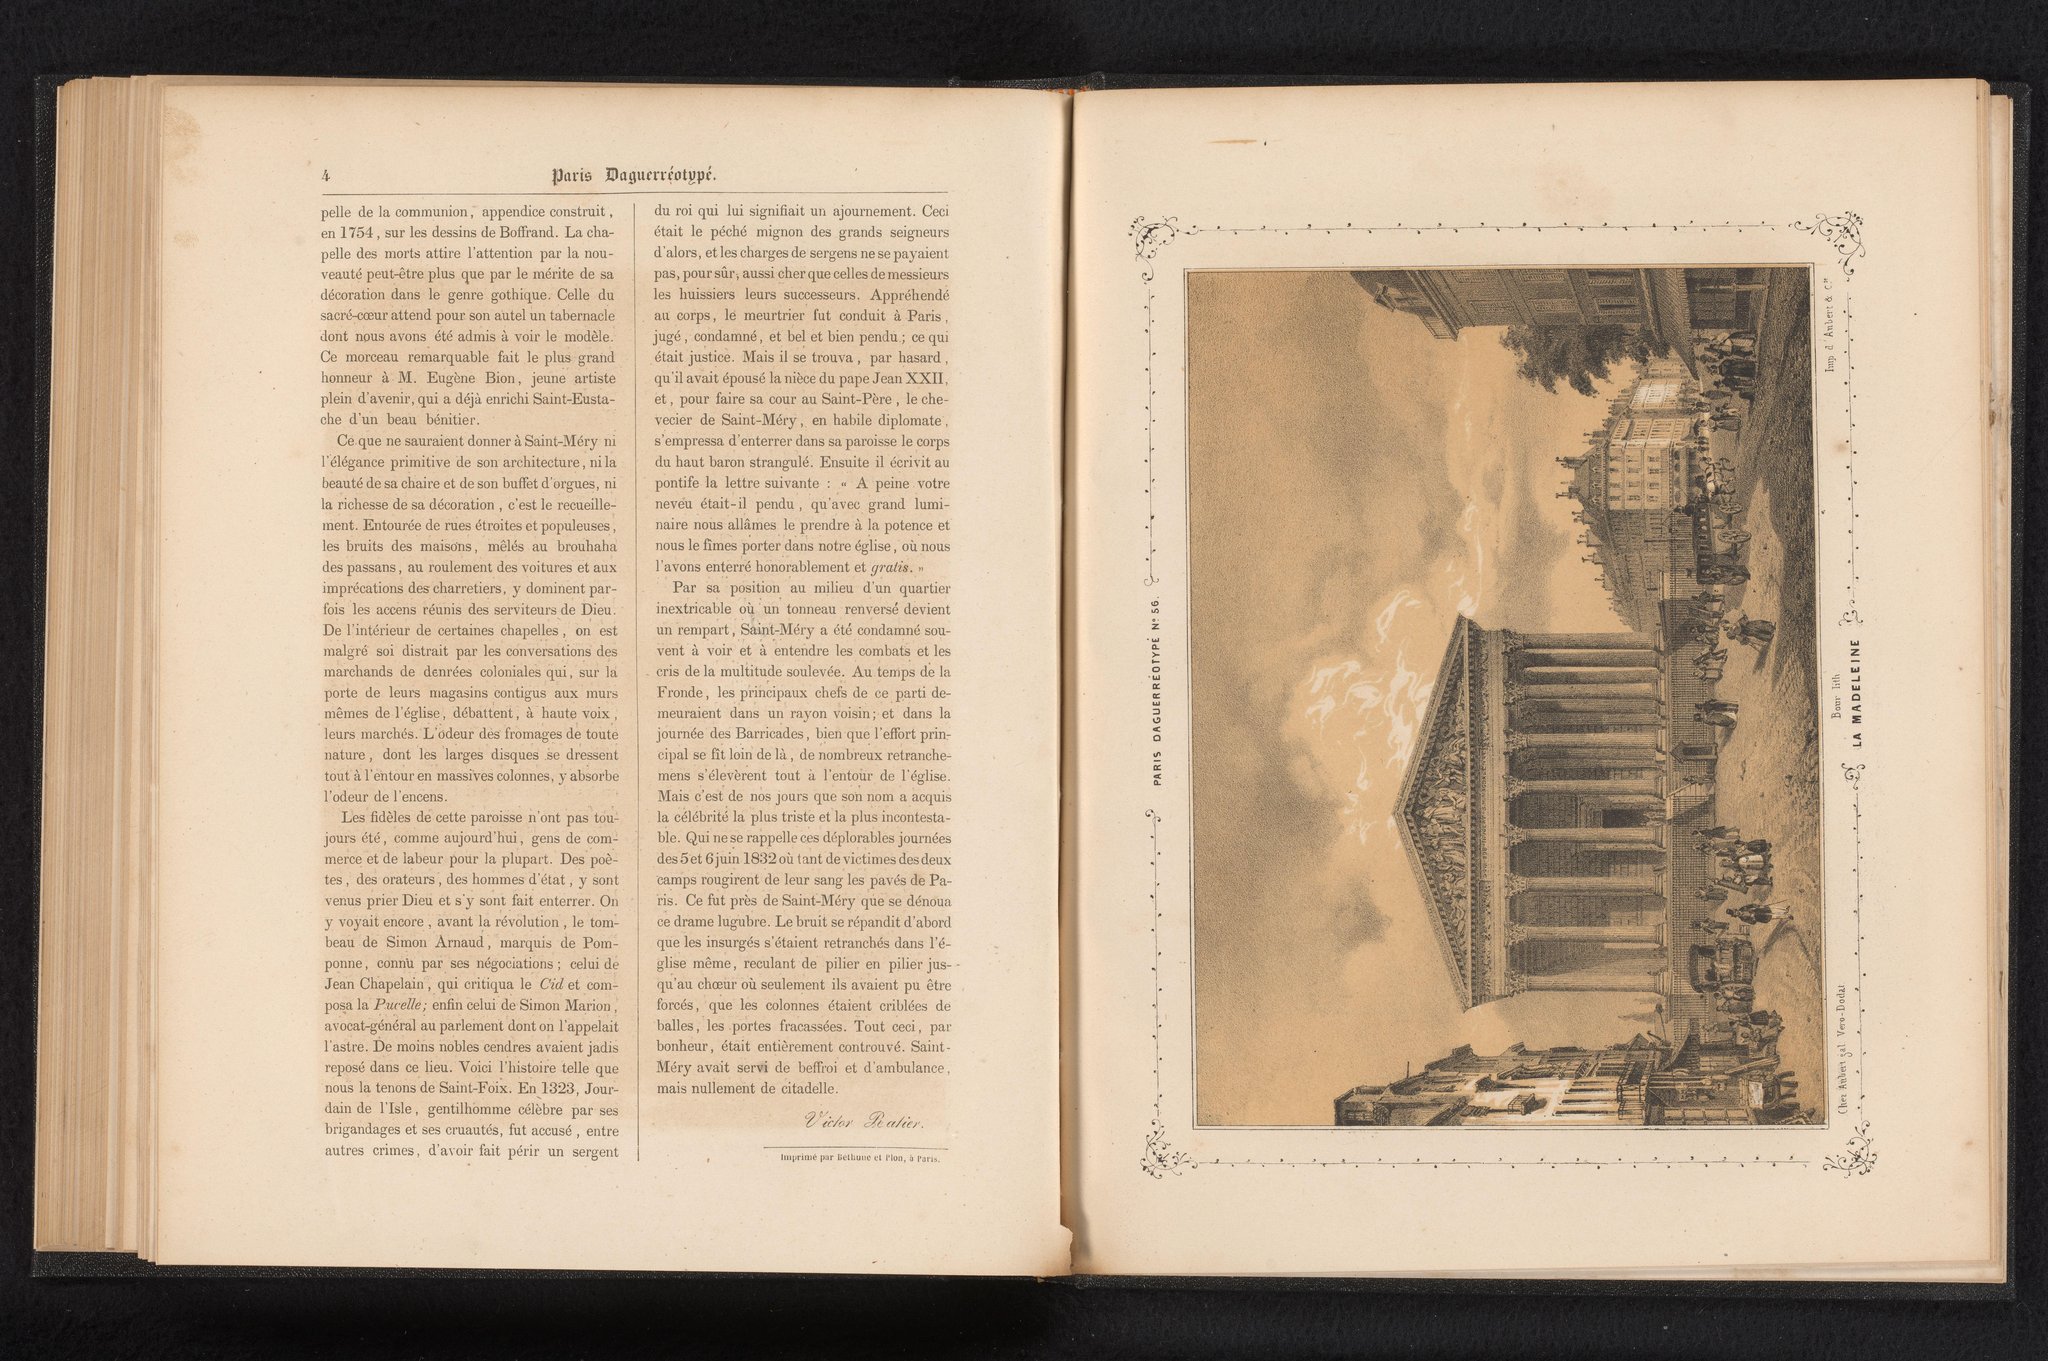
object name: page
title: La Madeleine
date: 1839-1840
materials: paper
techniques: tone lithography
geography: paris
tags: church (exterior)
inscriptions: inscription: ‘PARIS DAGUERRÉOTYPÉ No. 56.’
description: Prent op tweehonderddrieëntwintigste ongenummerde pagina.